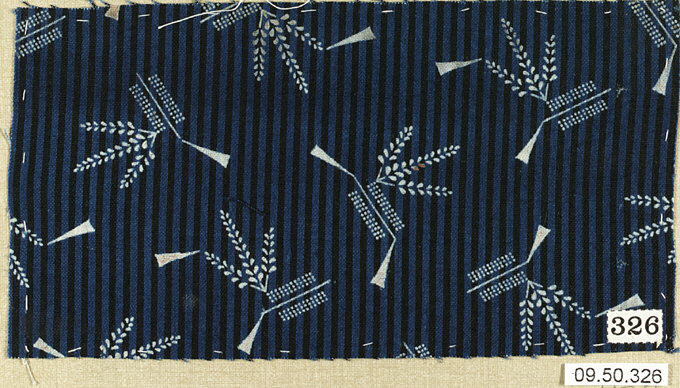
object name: piece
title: Piece (one of 116)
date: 1801-1900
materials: cotton